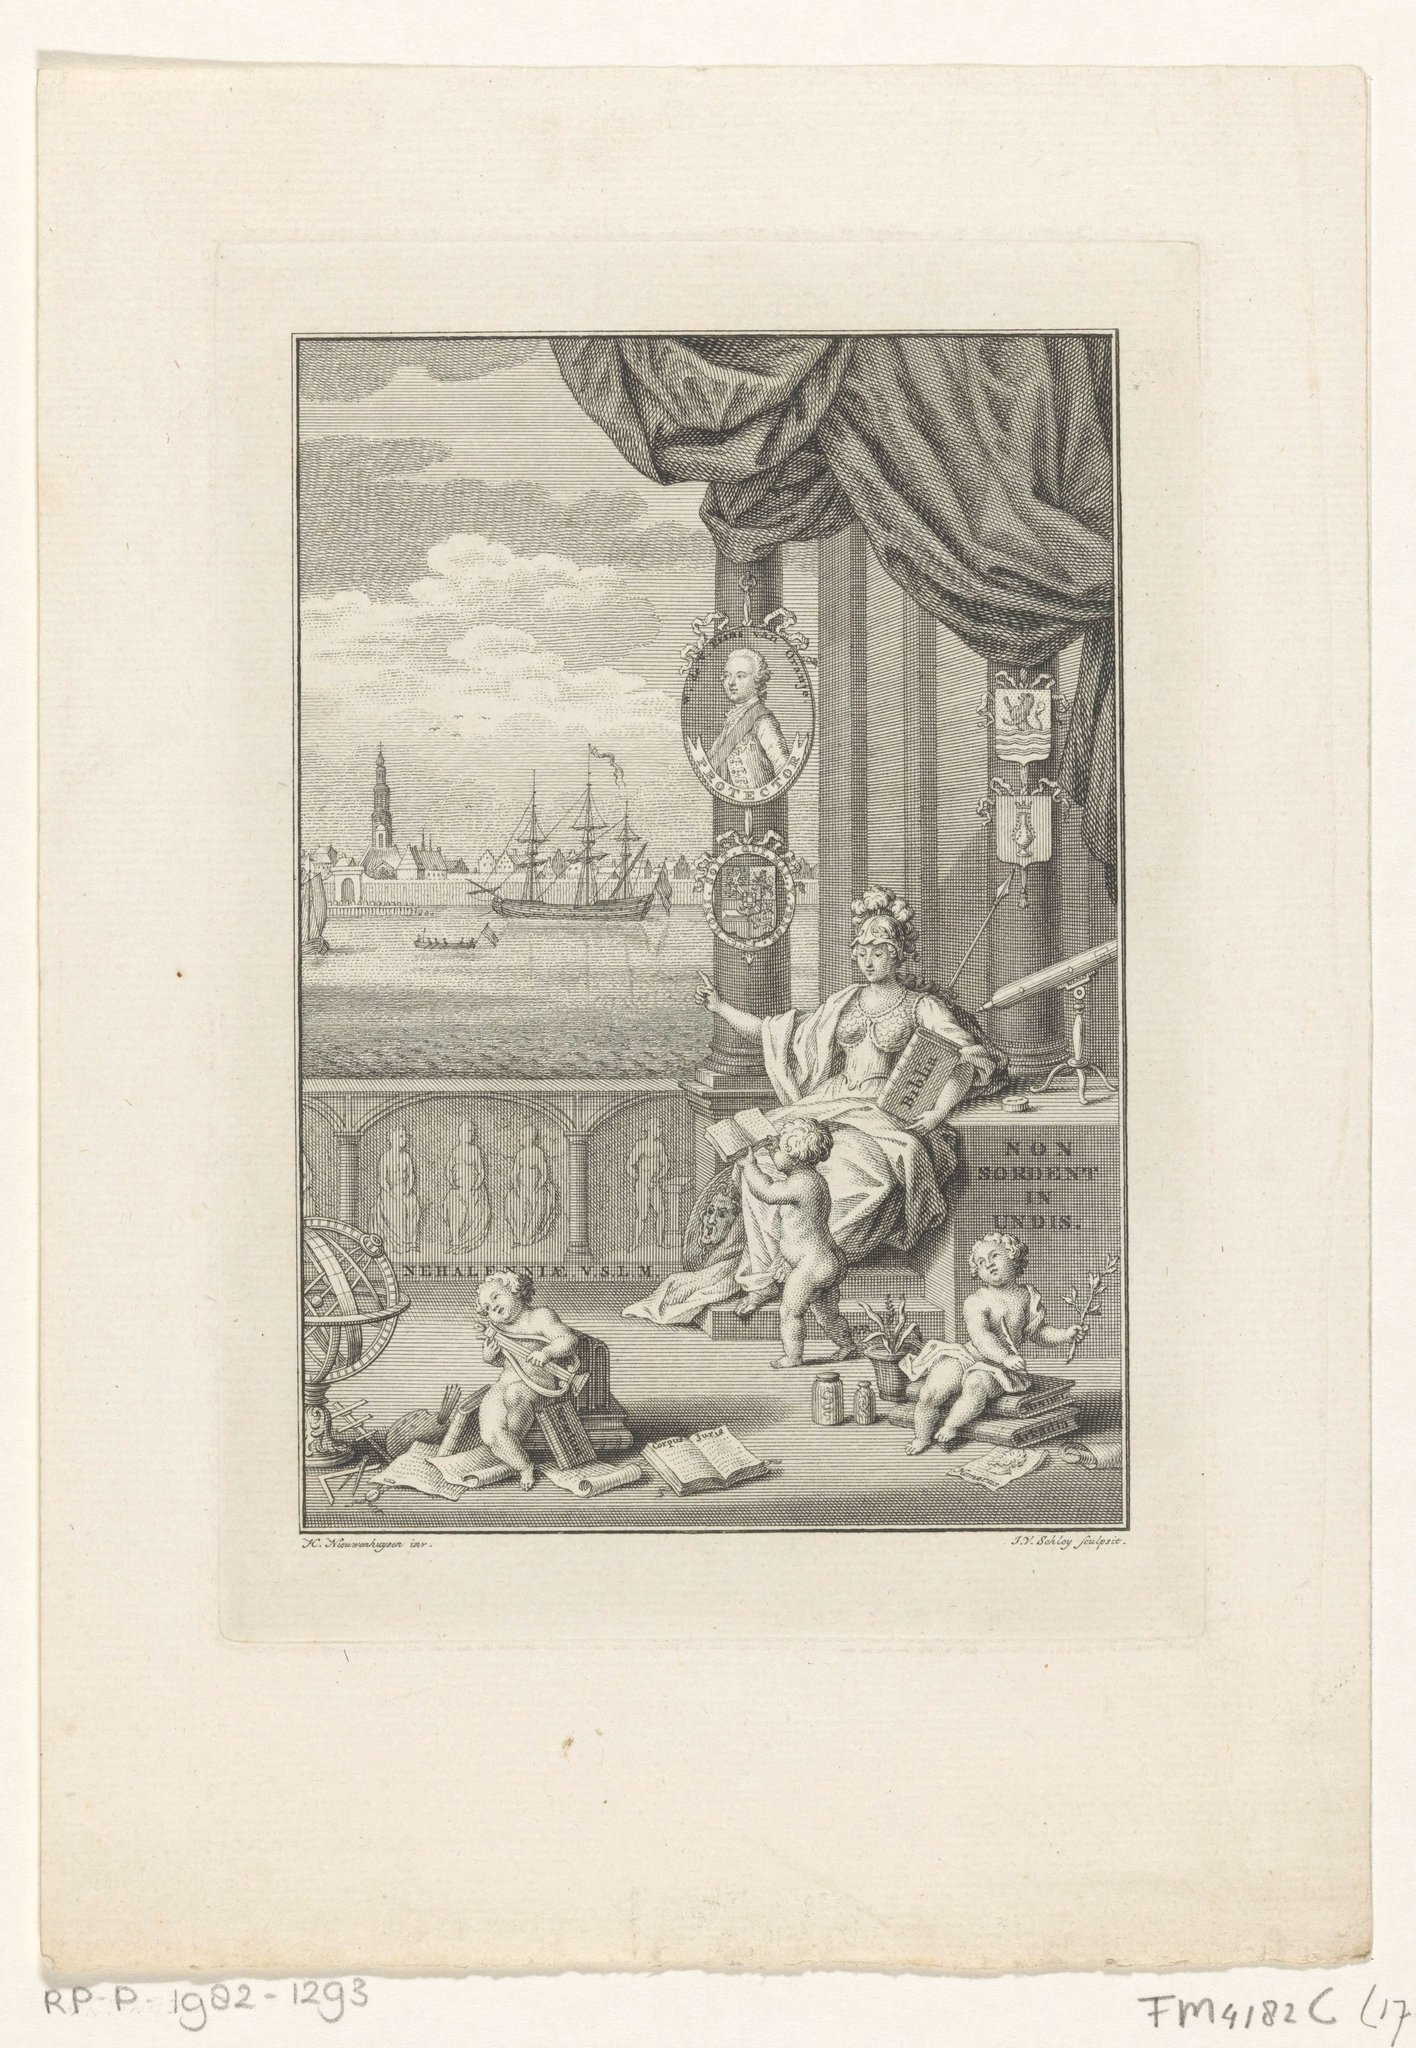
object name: titelblad, titelpagina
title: Titelpagina voor: S.n., Verhandelingen uitgegeven door het Zeeuwsch Genootschap der Wetenschappen te Vlissingen, dl. 1, 1769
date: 1769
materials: paper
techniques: engraving, etching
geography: leiden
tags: the hague, william v (prince of orange), specific aspects, allegorical aspects of minerva; minerva as patroness - veneration, honoured by, flushing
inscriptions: collector's mark: Lugt 2228, collector's mark: Lugt 2760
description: Minerva zittend met de bijbel in de hand wijst op de stad Vlissingen in de verte. Achter haar een zuil met medaillons met portret en wapen van stadhouder Willem V. Rechts het wapen van Zeeland met eronder het wapen van Vlissingen. Rondom zitten drie putti met boeken, een olijftak en een lier.